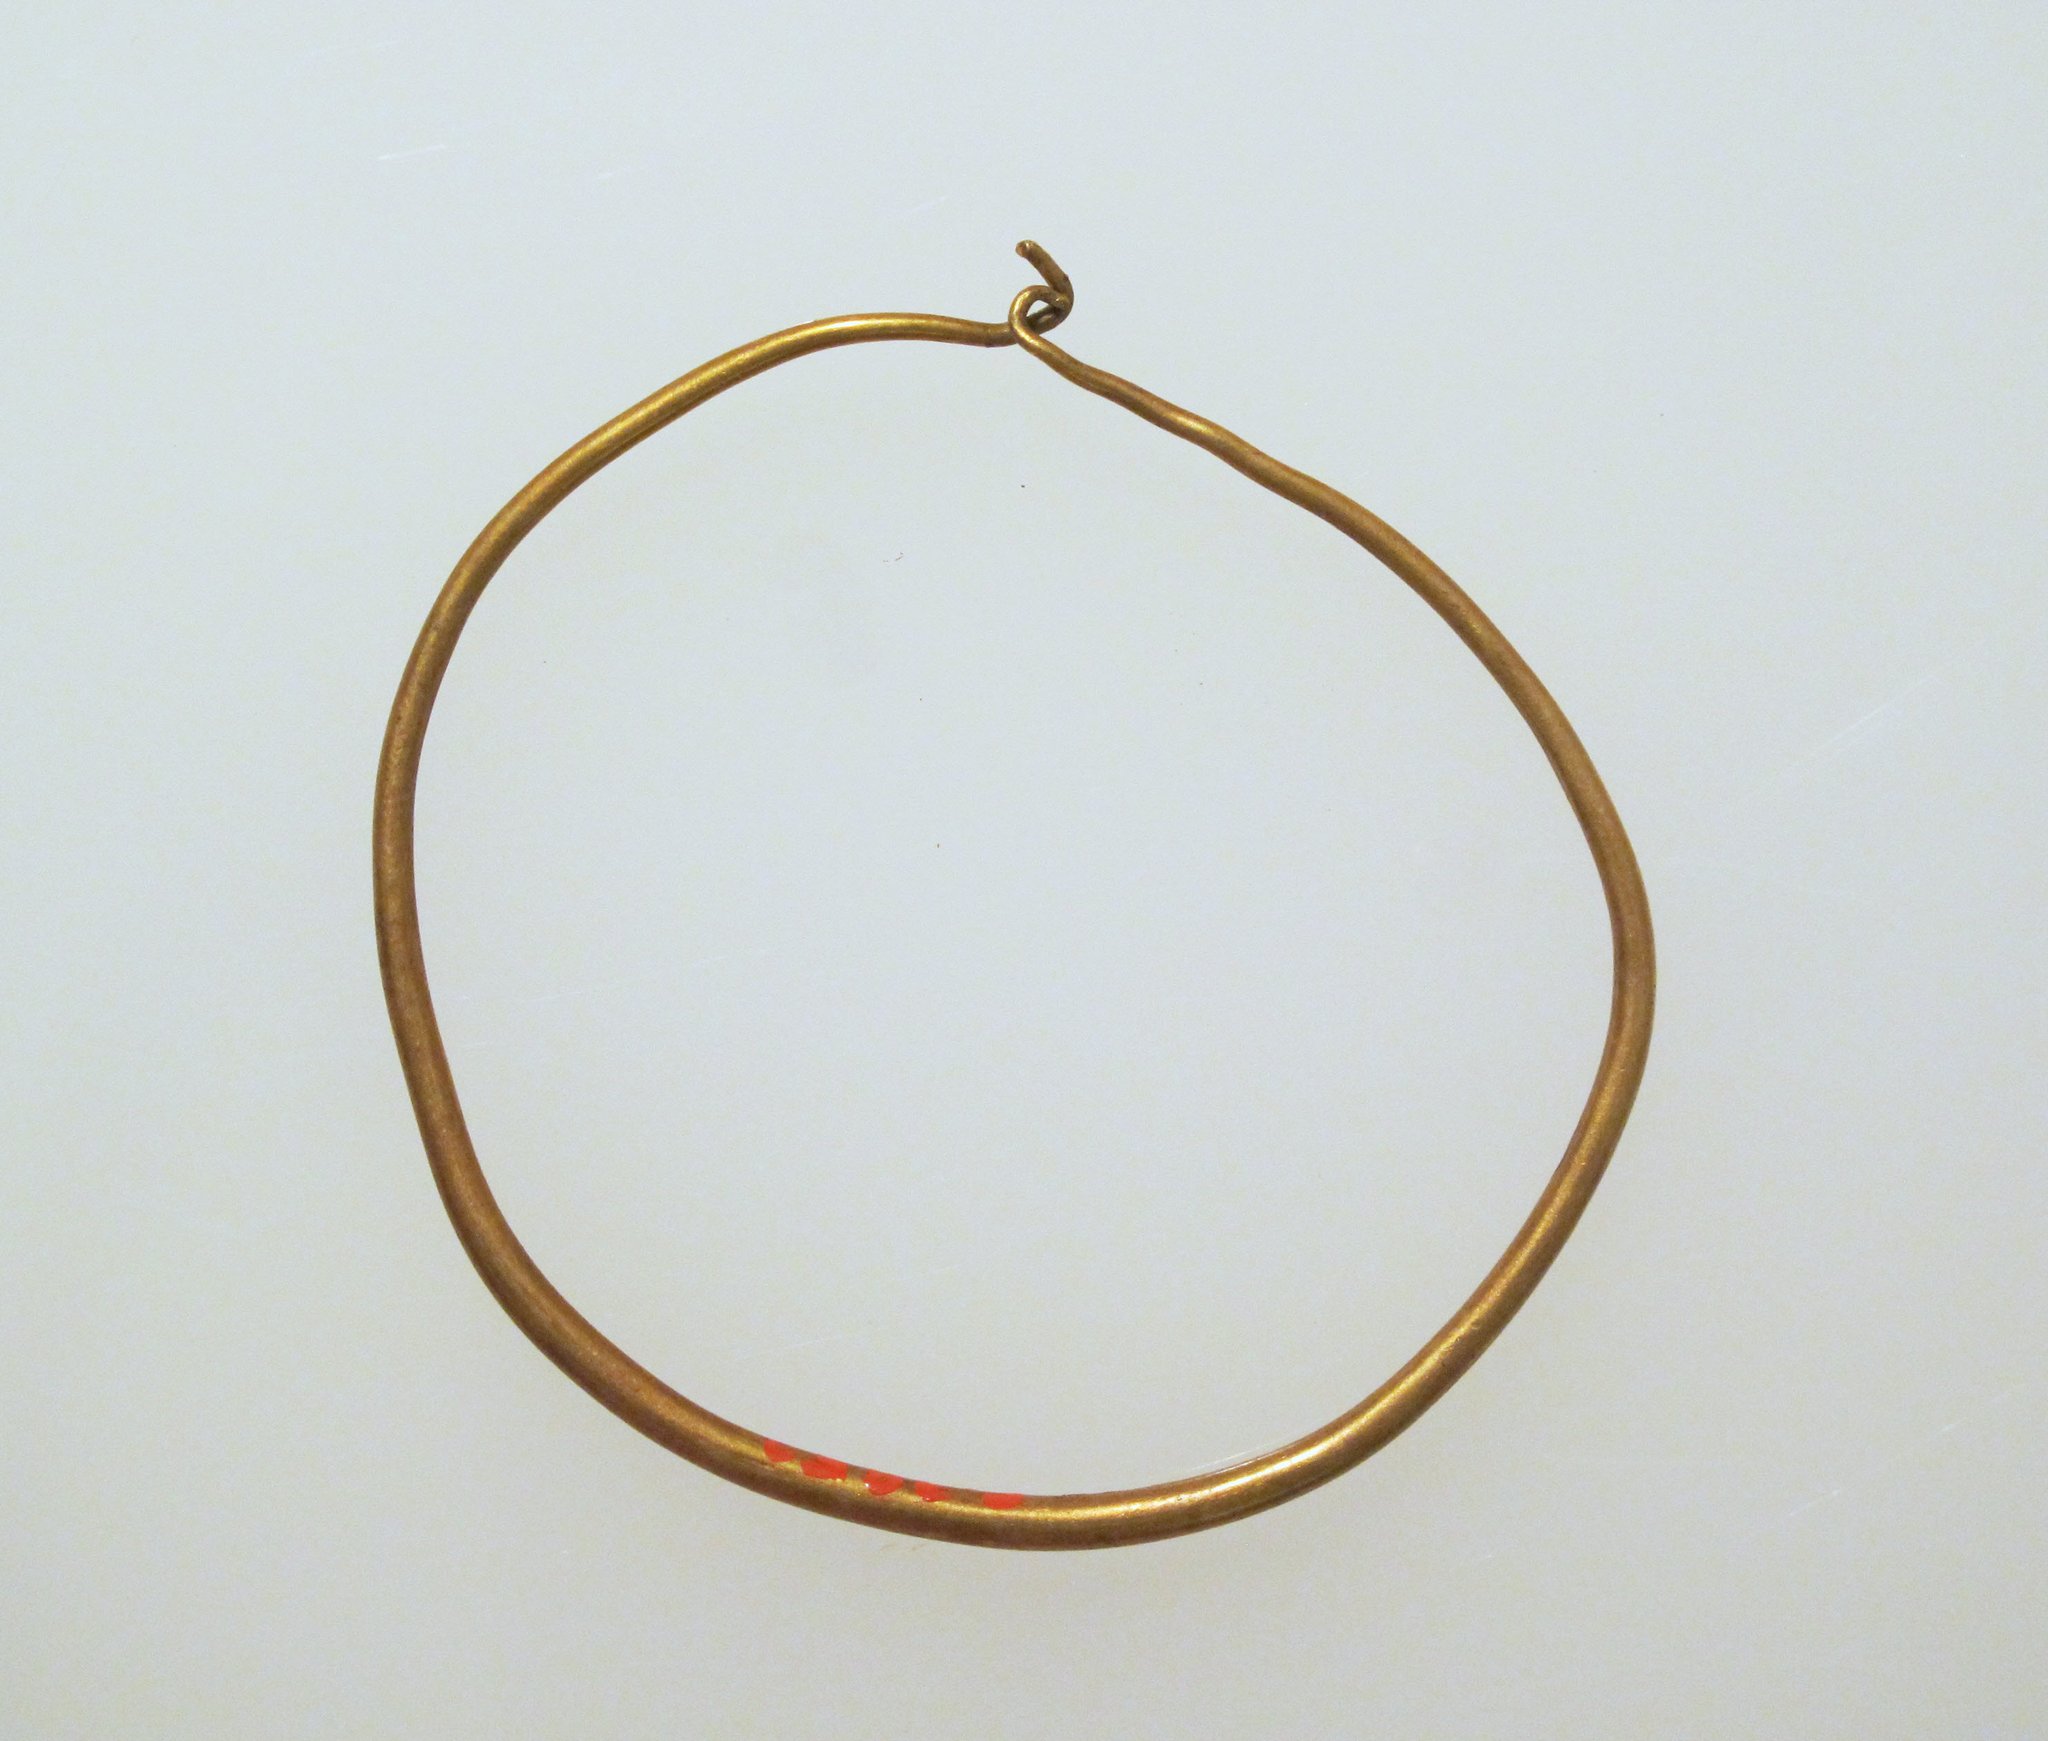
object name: earring loop type, plain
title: Earring-loop type, plain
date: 7000 BCE-330 CE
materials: gold